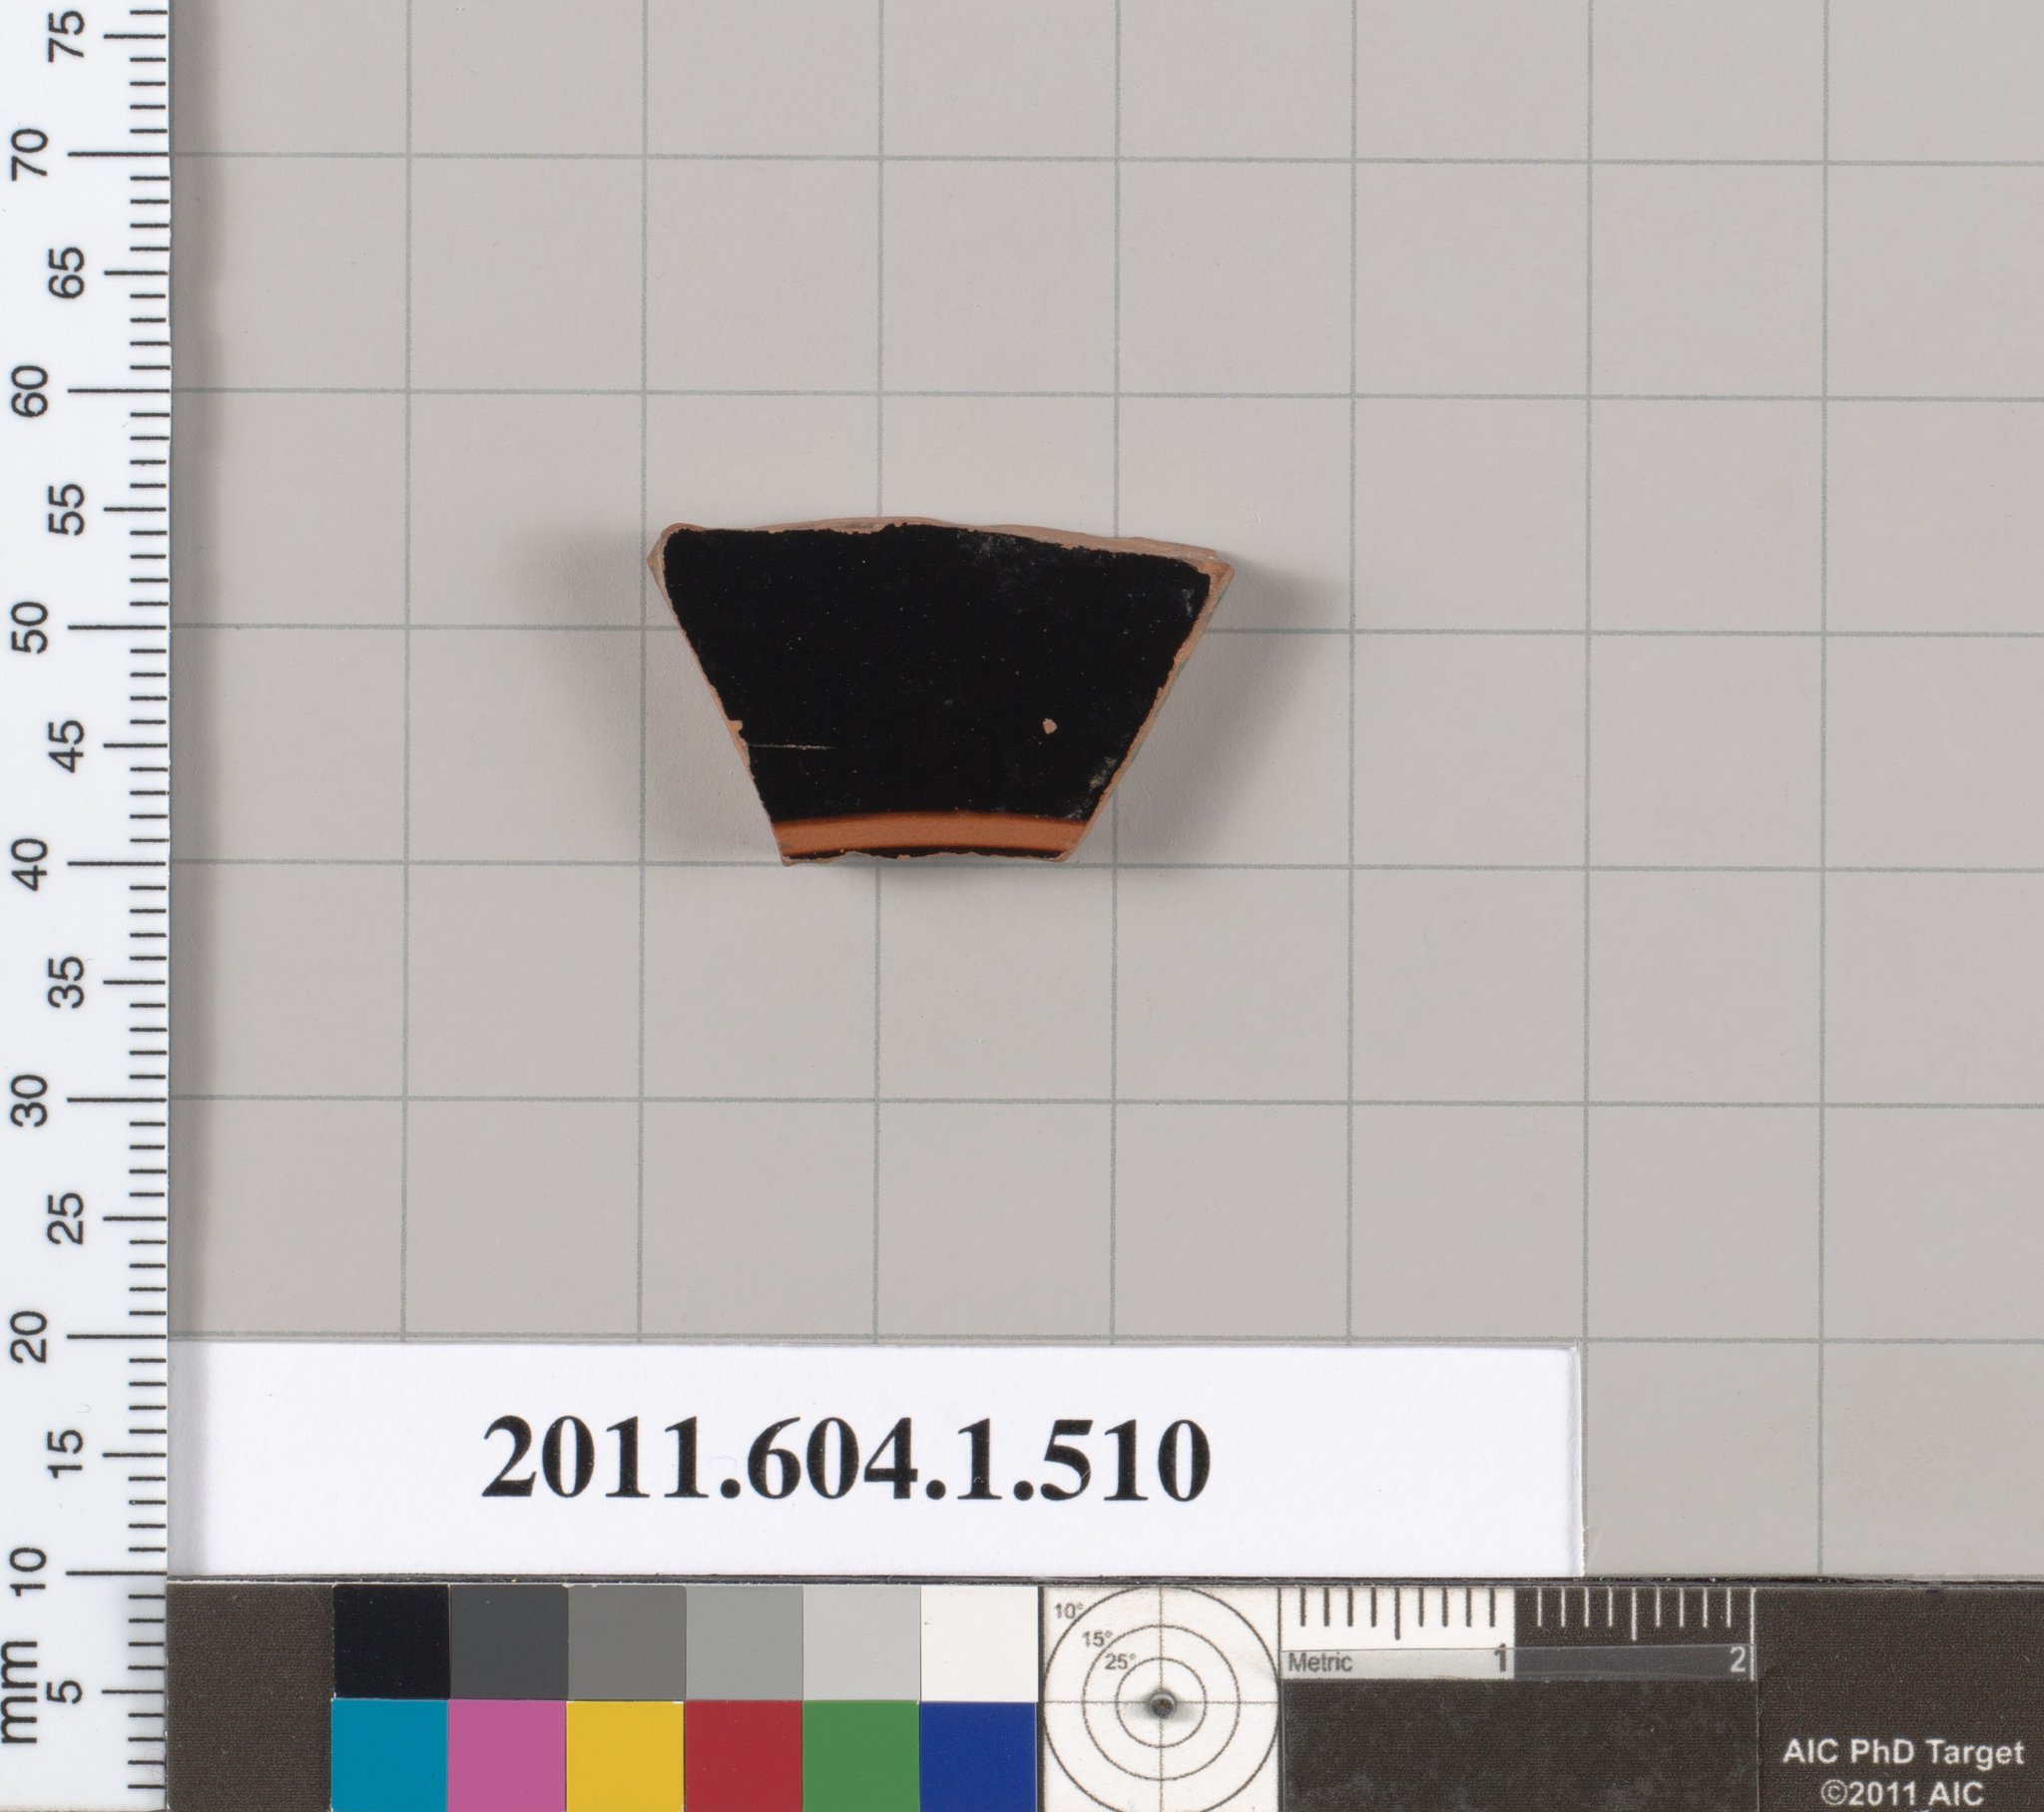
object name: kylix fragment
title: Terracotta fragment of a kylix (drinking cup)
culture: greek, attic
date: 500-476 BCE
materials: terracotta